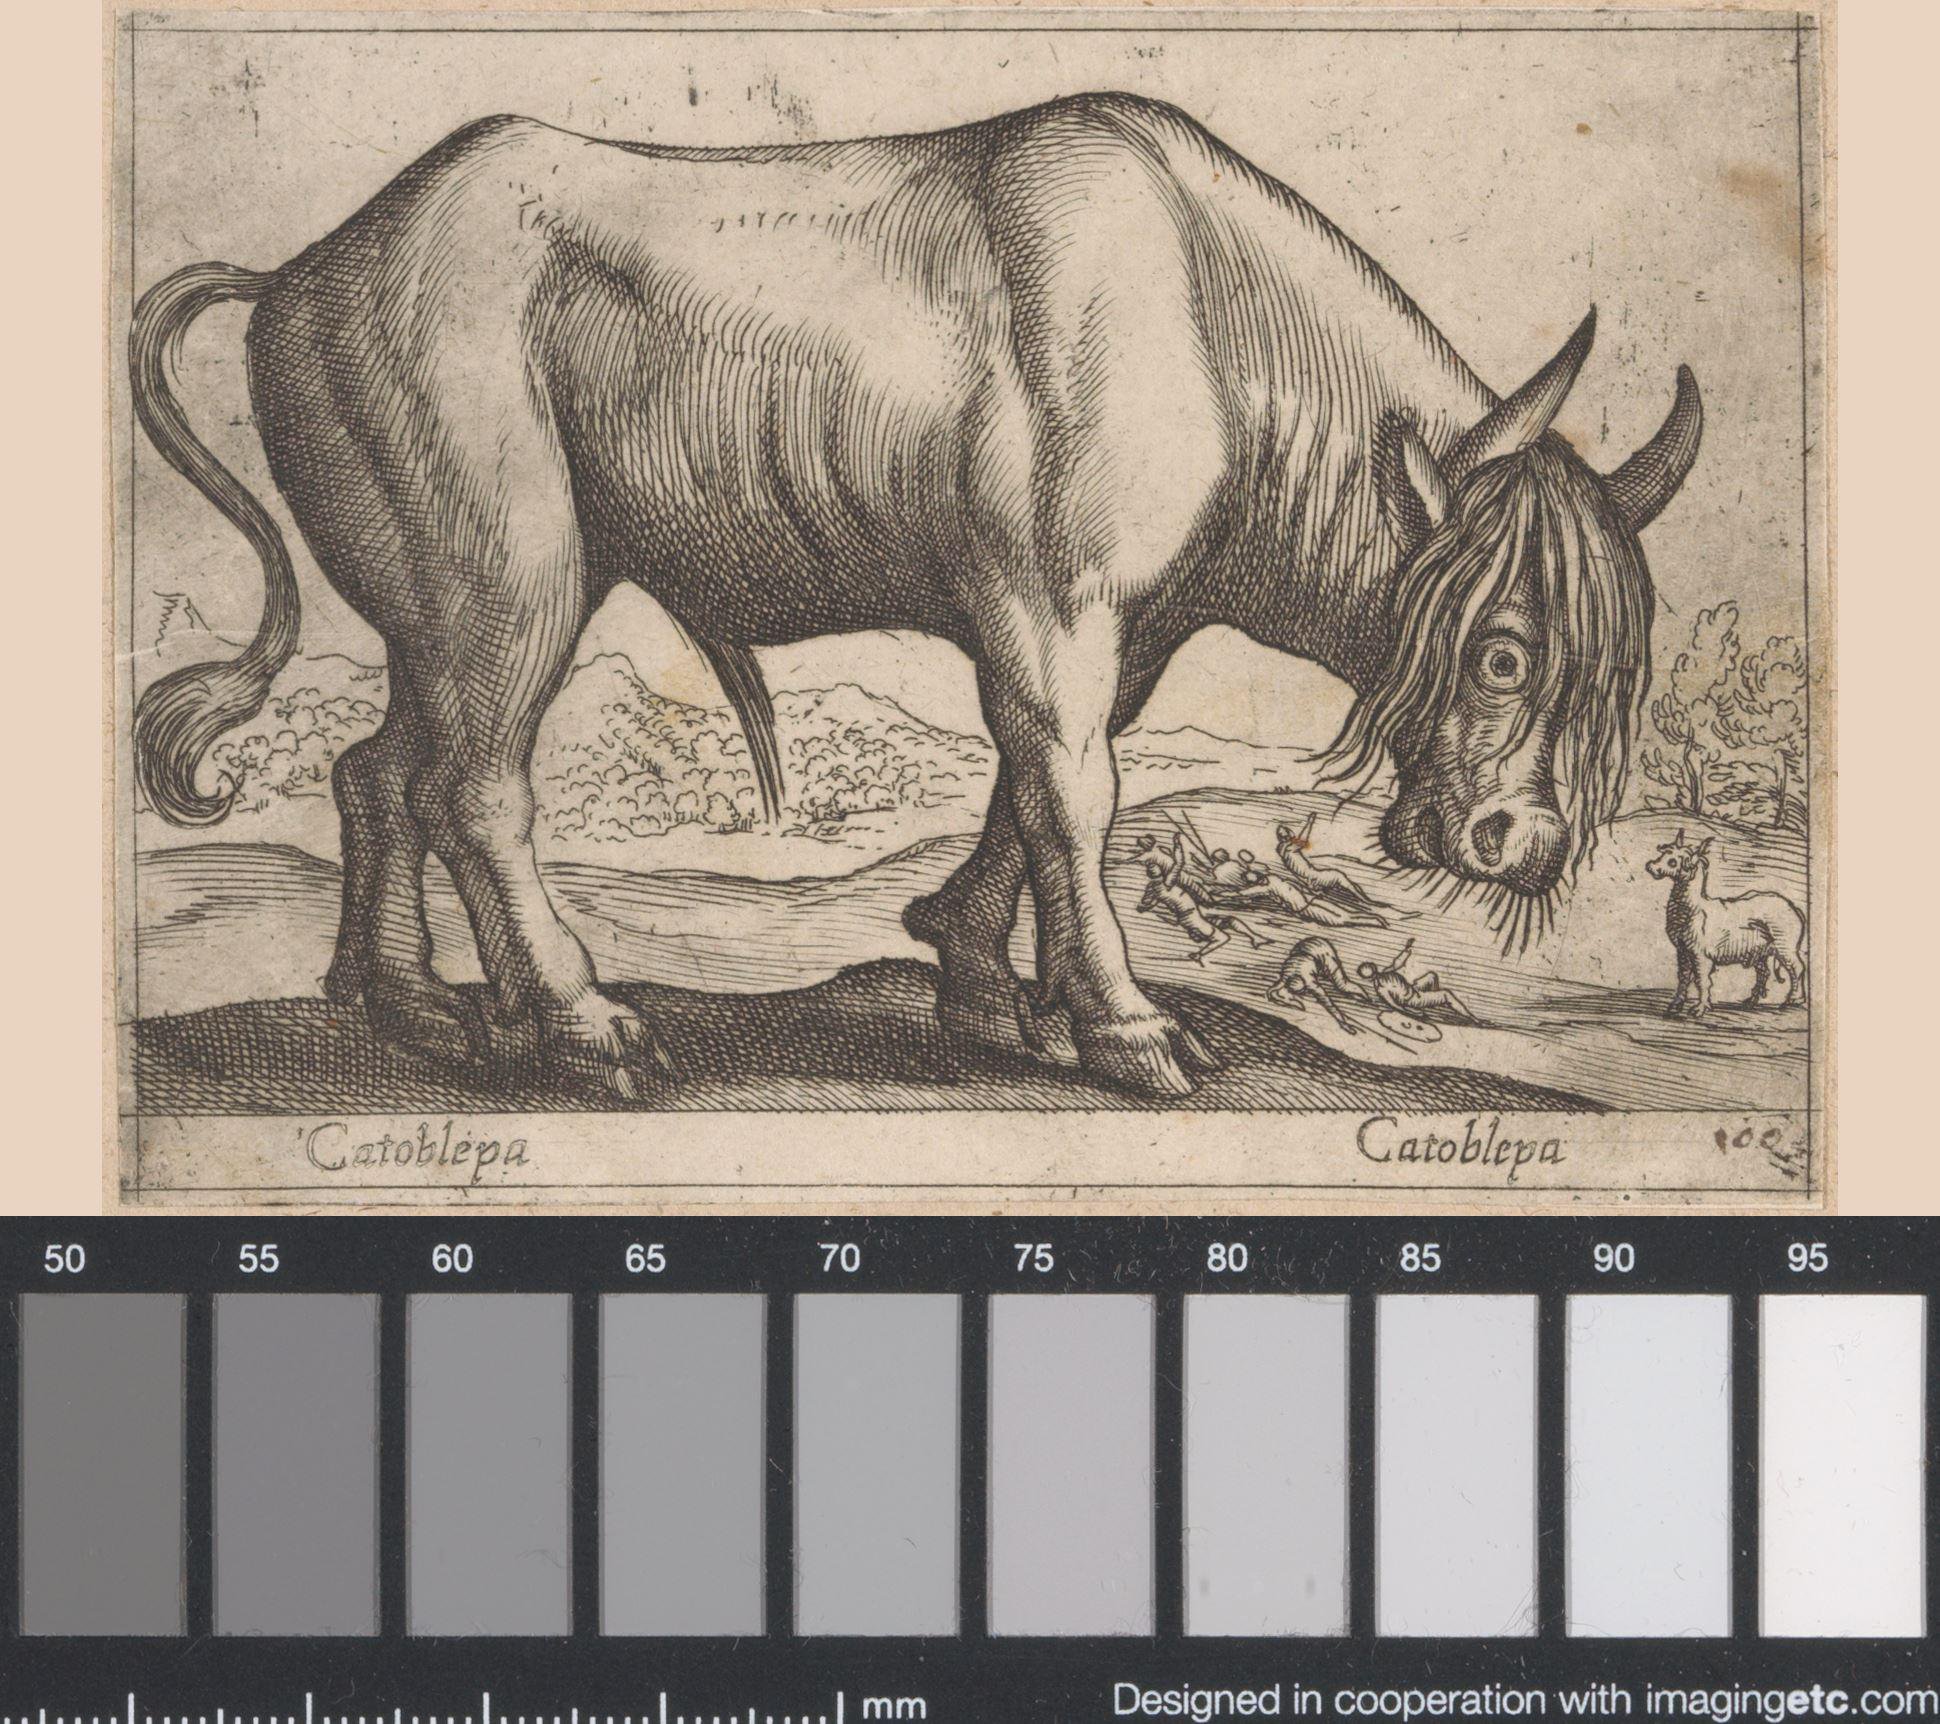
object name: print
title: Rund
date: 1565-1630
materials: paper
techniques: etching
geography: rome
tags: ox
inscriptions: number: ‘100’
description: Deze prent maakt deel uit van een reeks prenten van dieren door Antonio Tempesta. Bekend is dat een tweede staat (met nummering) van deze serie is uitgegeven door Giovanni Giacomo de' Rossi in 1650. Onbekend is wie de eerste staat heeft uitgegeven en wanneer.